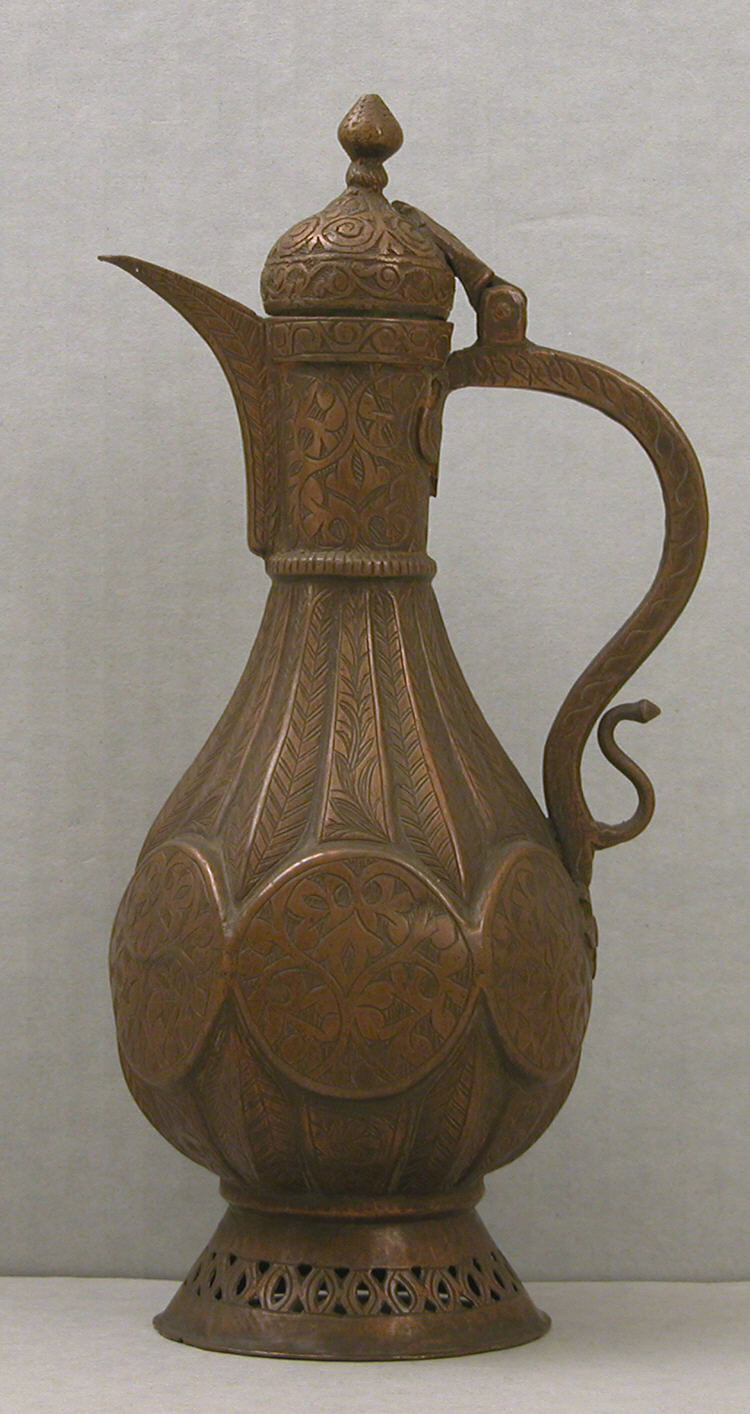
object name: coffee pot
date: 1801-1900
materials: copper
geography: china